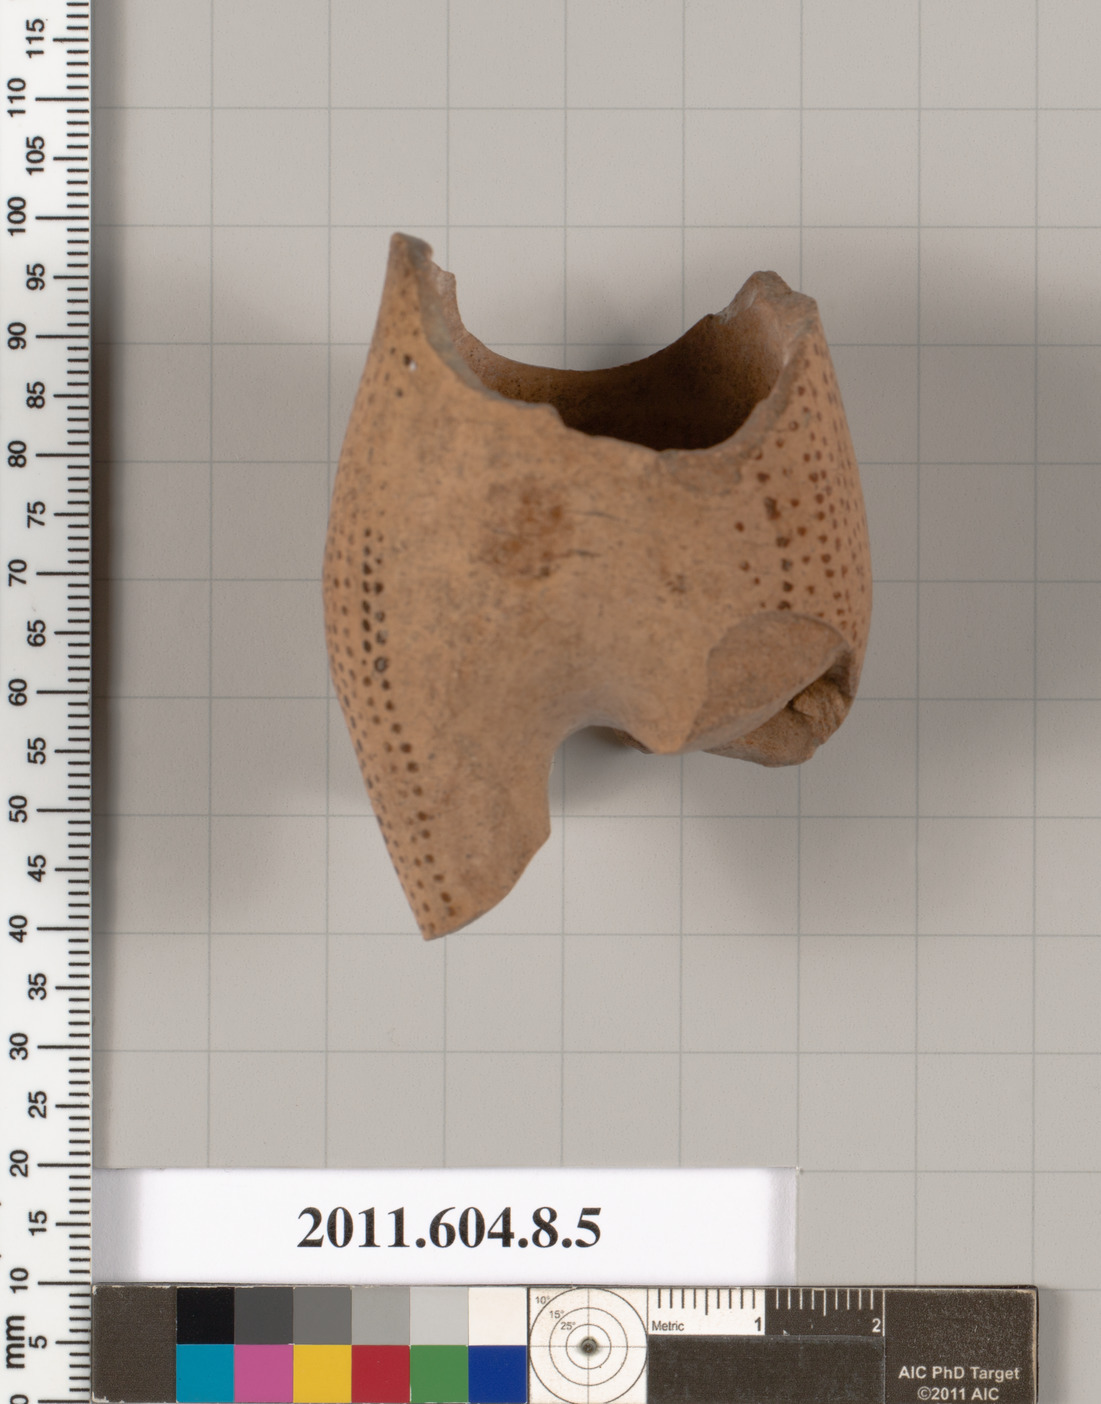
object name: aryballos in the form of a hare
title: Terracotta fragment of a vase in the form of a hare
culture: greek, corinthian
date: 600-568 BCE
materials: terracotta